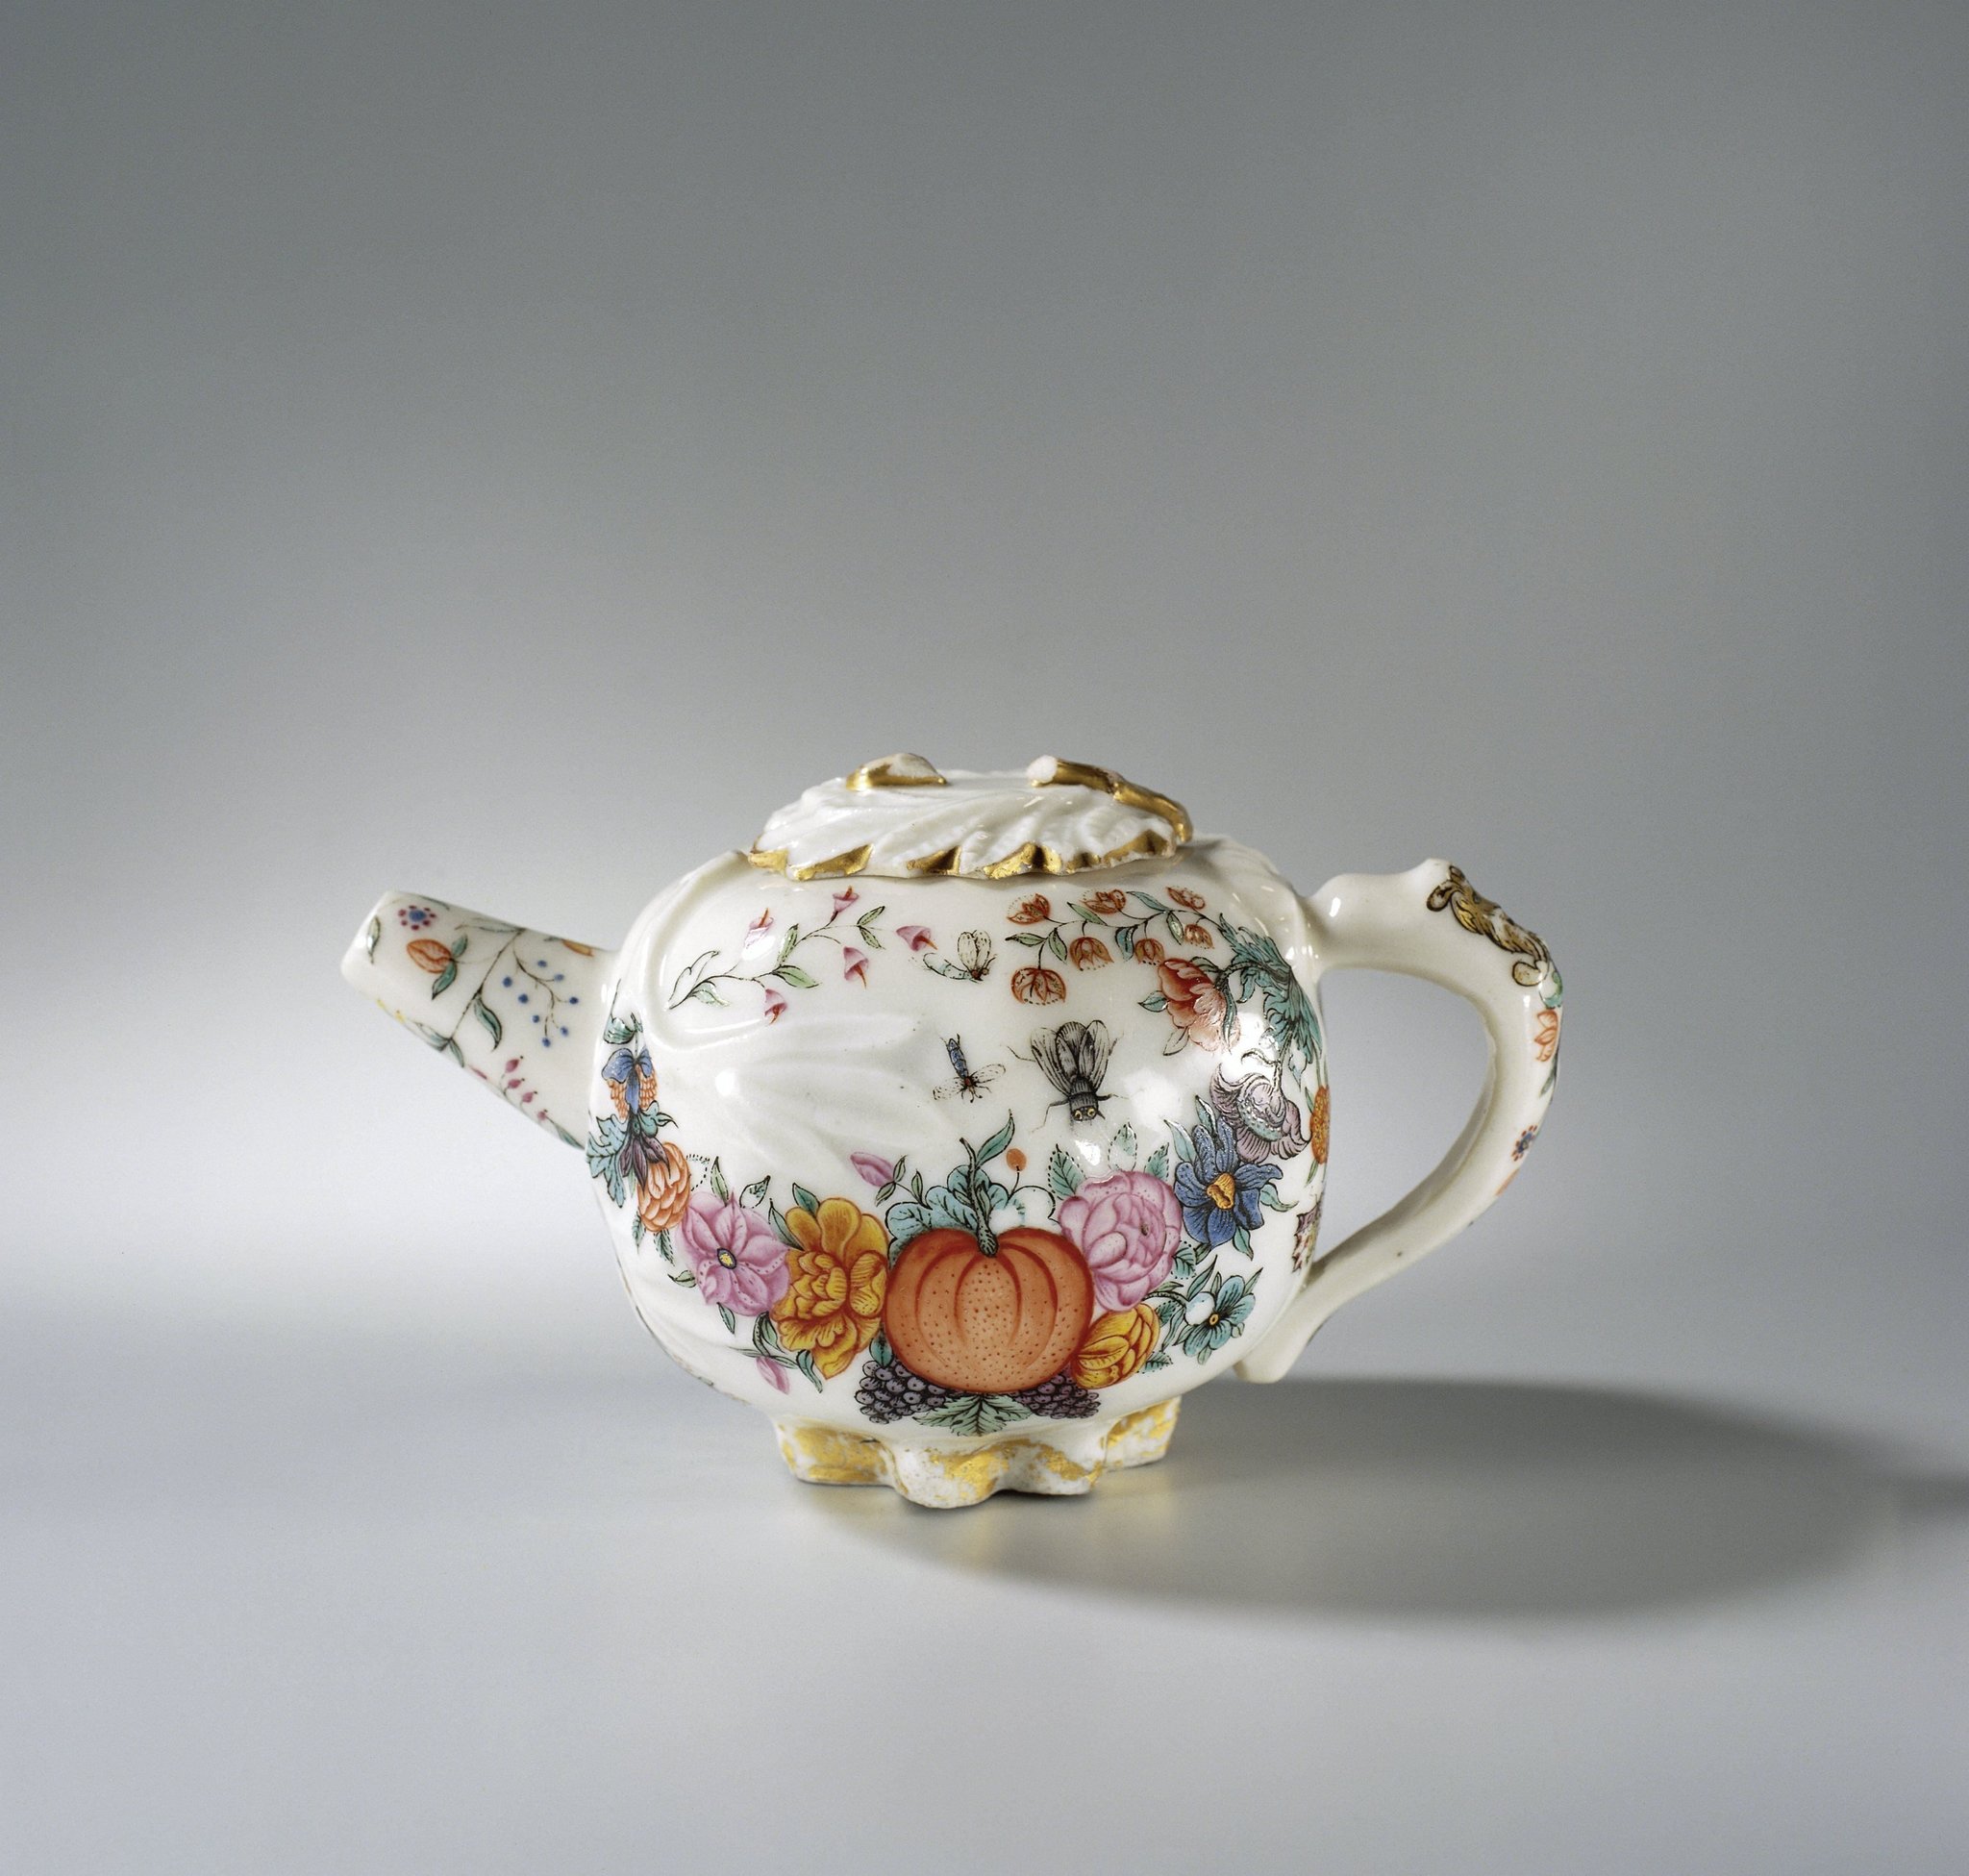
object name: teapot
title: Teapot with sprays in relief, a garland and flowering plants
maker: Anonymous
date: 1675-1724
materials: glaze, gold, paint, porcelain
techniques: firing, gilding, turning, vitrification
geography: china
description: Trekpot van poselein. Beschilderd met bloemslingers en een vergulde, stervormige voet. Hoogstwaarschijnlijk in Duitsland beschilderd.